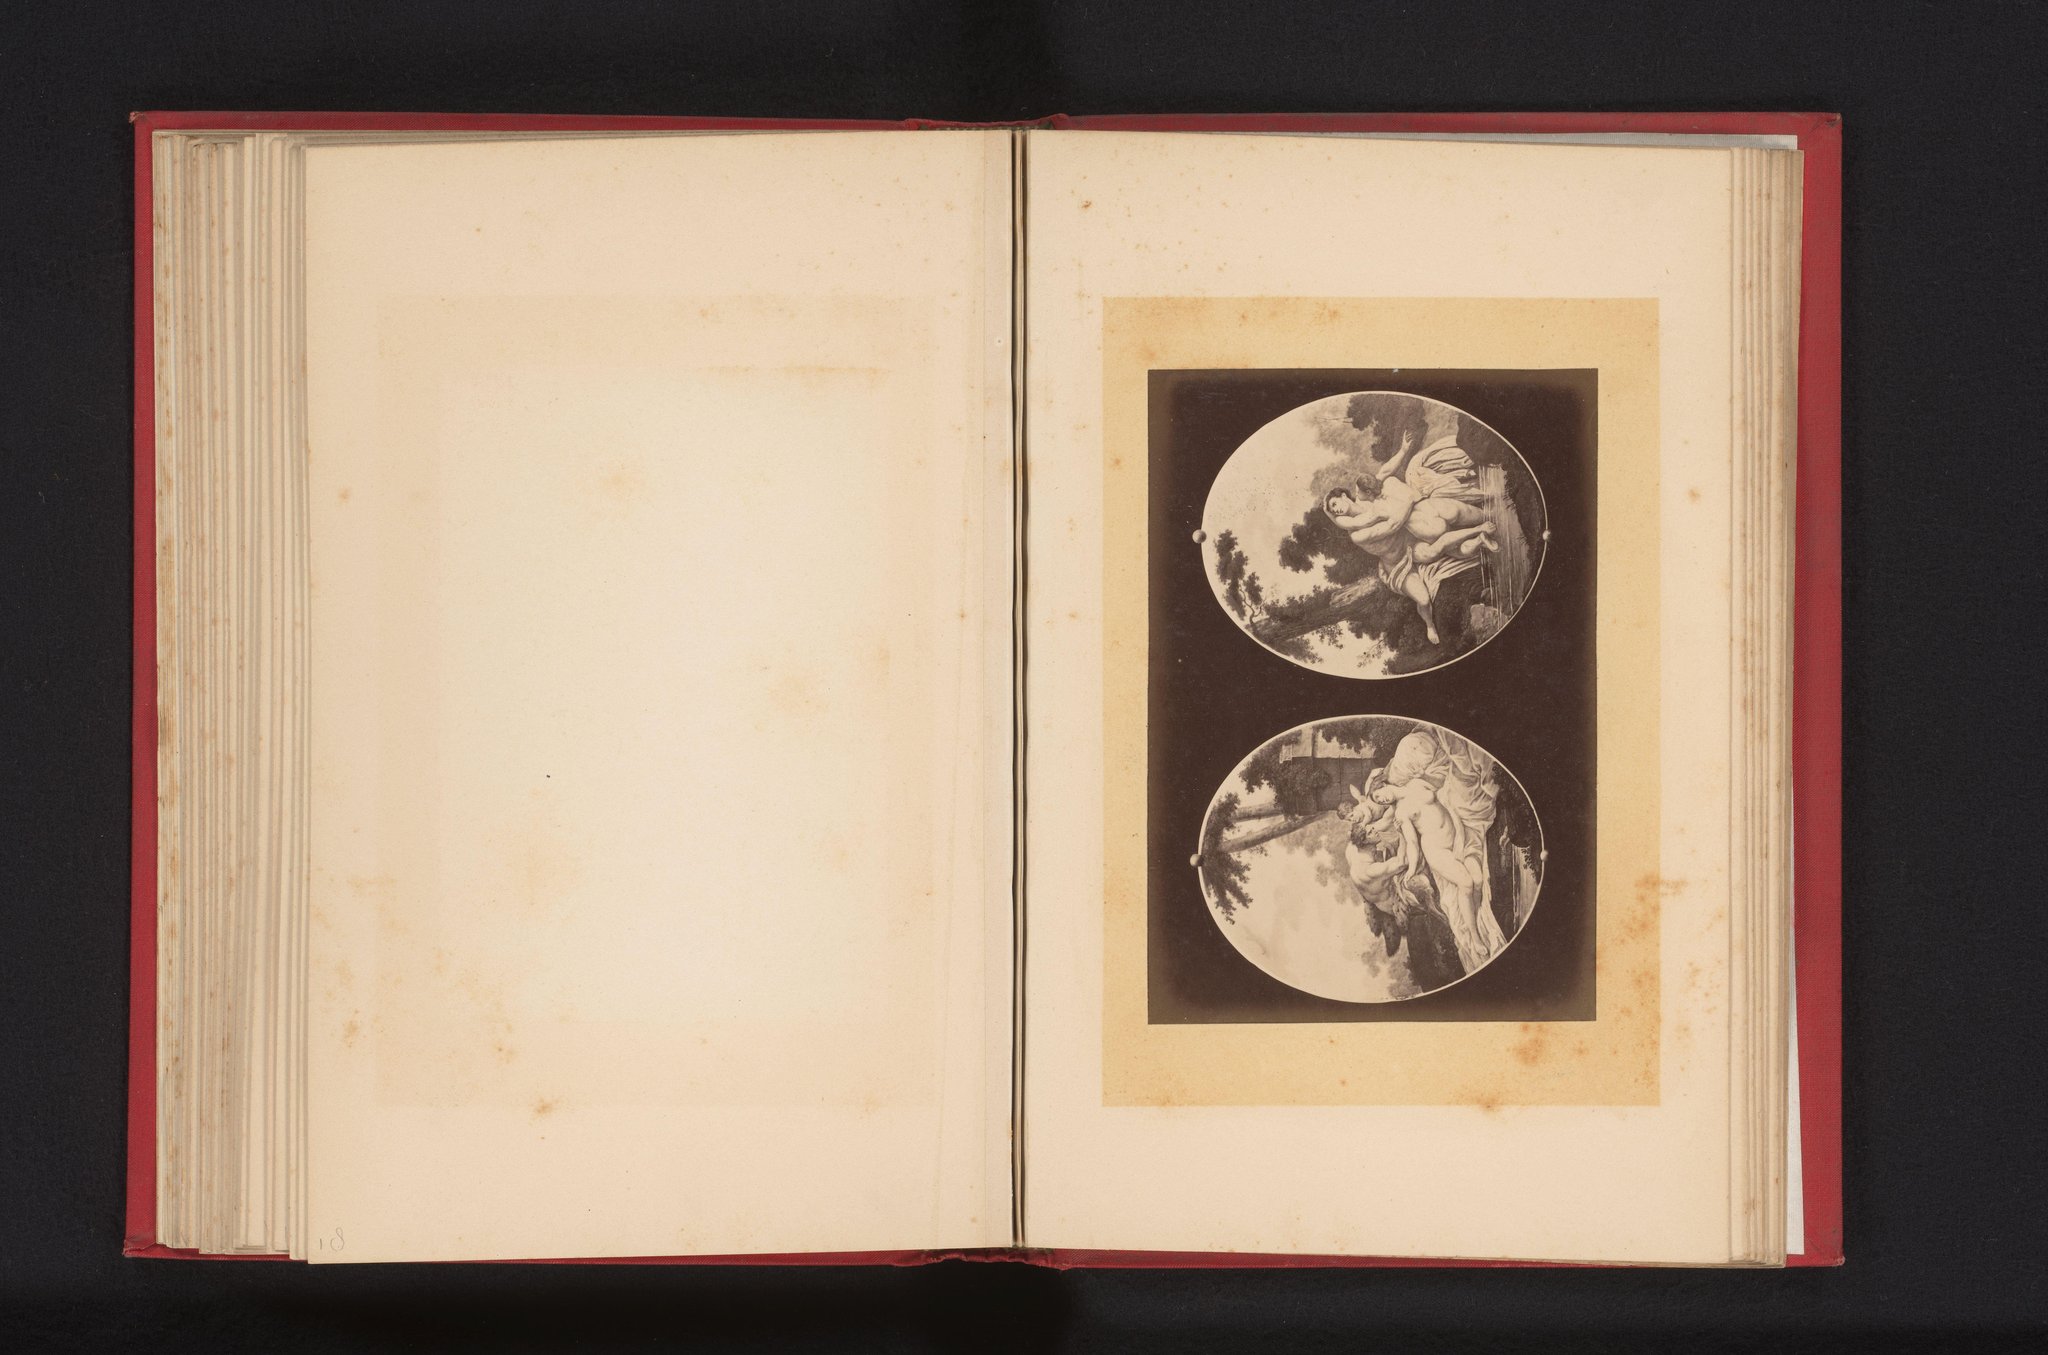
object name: photograph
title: Twee ovale werken met mythologische voorstelling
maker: Anonymous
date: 1872-1878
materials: photographic support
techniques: albumen print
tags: classical mythology and ancient history